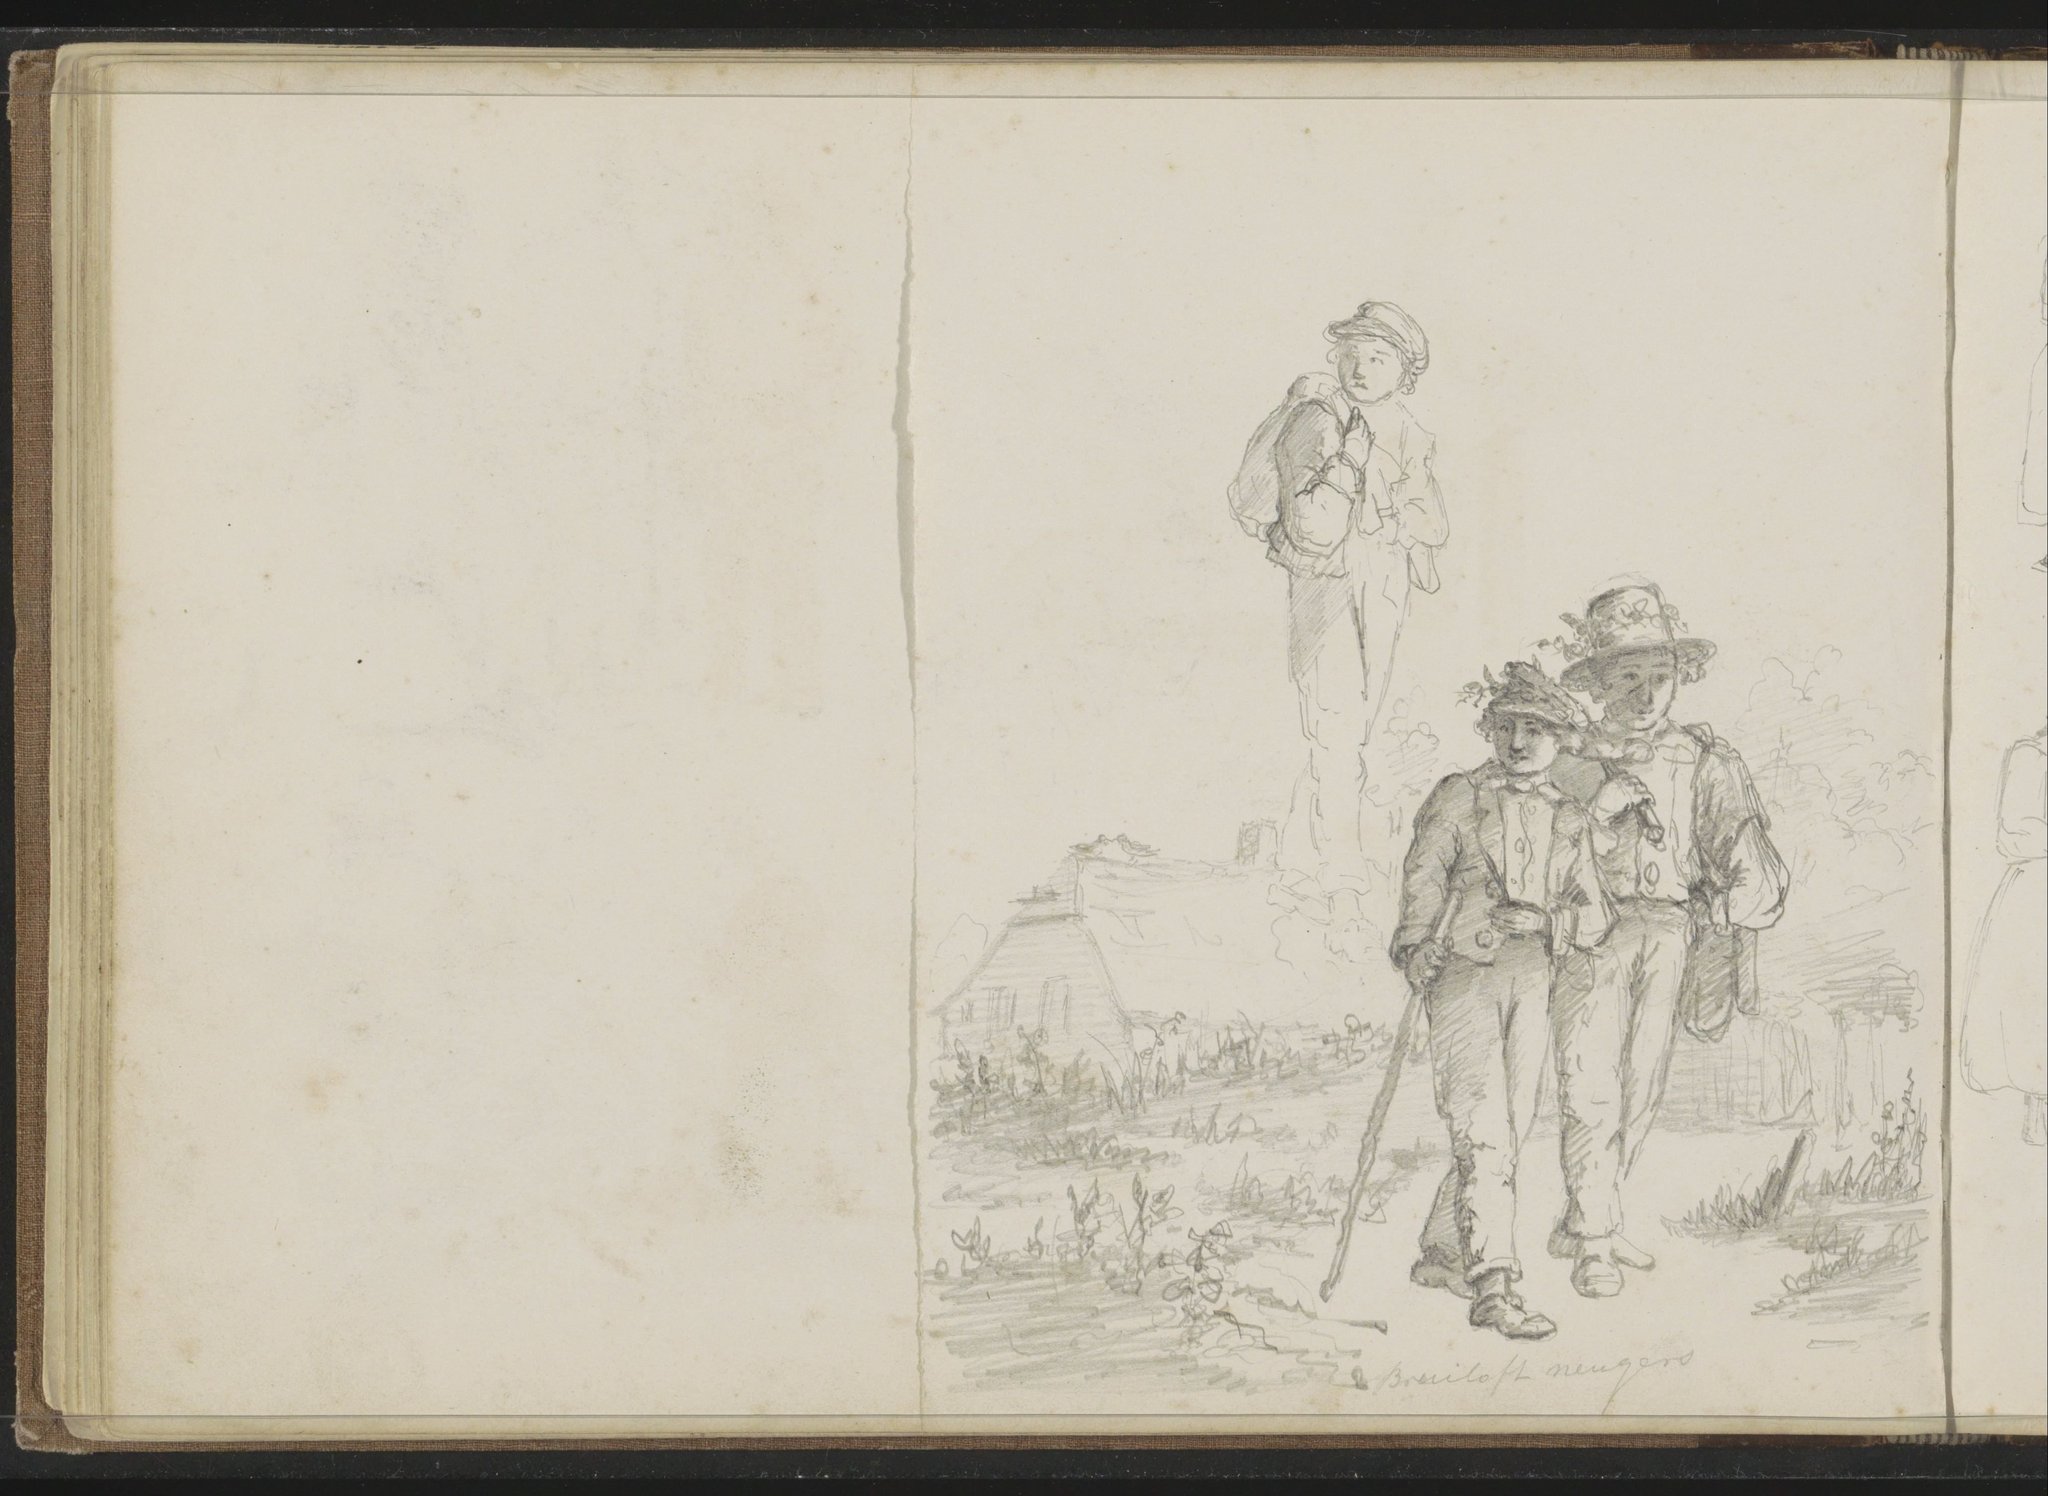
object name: sketchbook leaf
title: Twee bruiloftsneugers op een pad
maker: hendrik valkenburg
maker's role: draughtsman, painter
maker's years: 1826-1896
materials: paper, pencil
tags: boy (child between toddler and youth)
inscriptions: annotation: ‘Bruiloft neugers’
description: Twee jongens met hoge hoeden versierd met bloemen lopen op een pad in een landschap. Op de achtergrond is een boerenwoning te zien. Eén van de jongens draagt een wandelstok. Tevens een studie van een jongen met een knapzak. Blad 35 verso uit een schetsboek met 77 bladen.